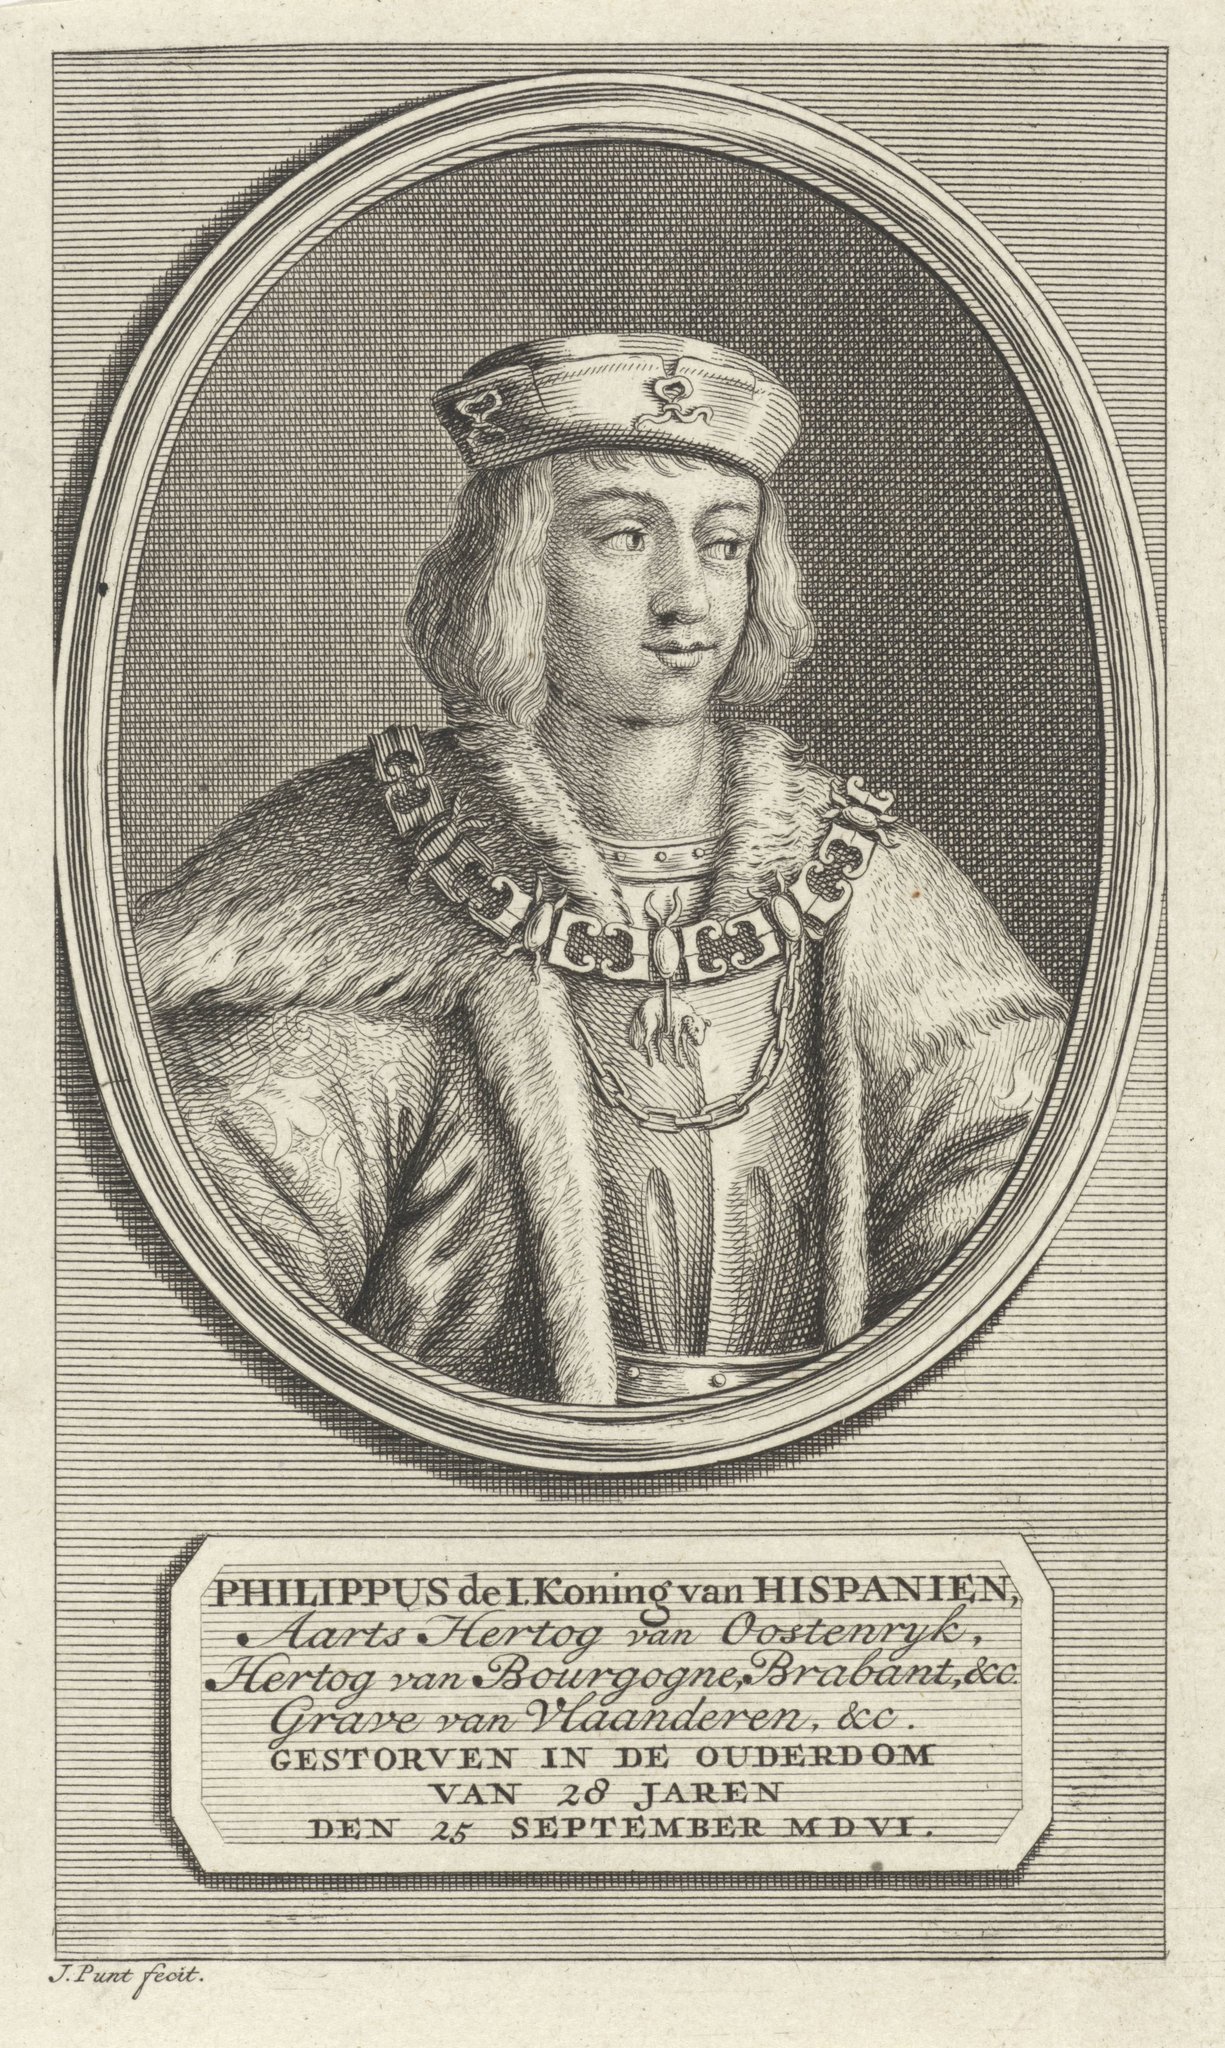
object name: print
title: Portret van Filips de Schone, hertog van Bourgondië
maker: jan punt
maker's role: draughtsman, print maker, publisher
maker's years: 1711-1779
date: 1786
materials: paper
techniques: engraving, etching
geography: northern netherlands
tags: filips de schone (hertog van bourgondië), knighthood order of the golden fleece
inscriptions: collector's mark: Lugt 2228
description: Prent gebruikt als illustratie in: Meteren, Emanuel van. Oorlogen en geschiedenissen der Nederlanderen en derzelver nabuuren, deel I, p. 73. Amsterdam: Steven Jacobus Baalde, 1786.